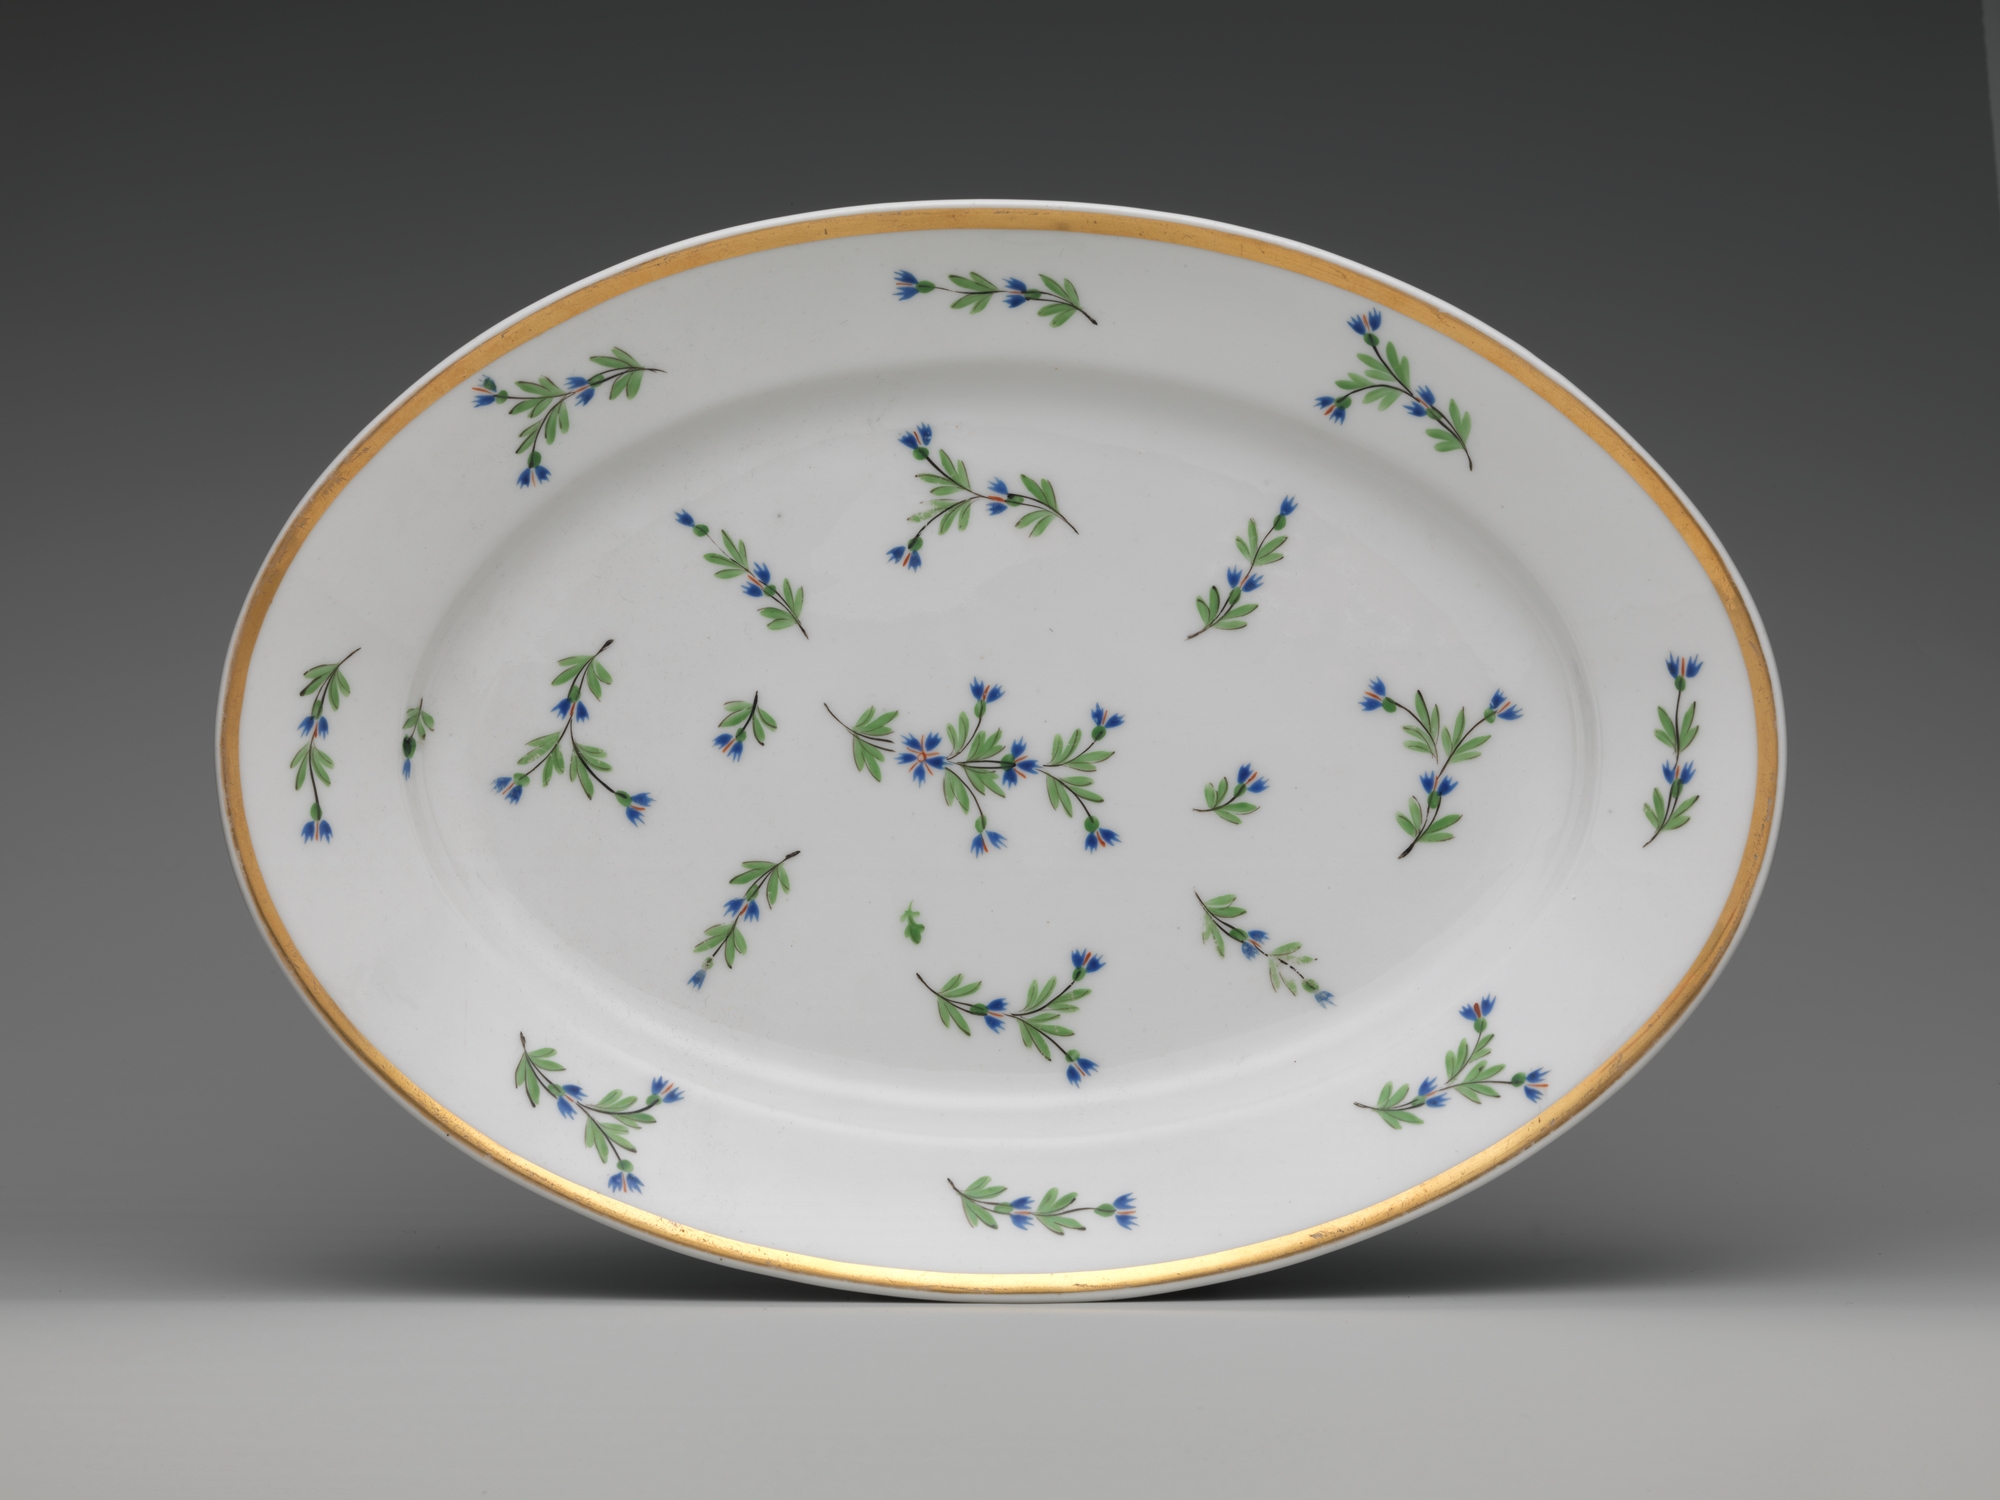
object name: platter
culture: french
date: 1815-1830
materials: porcelain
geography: france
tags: flowers